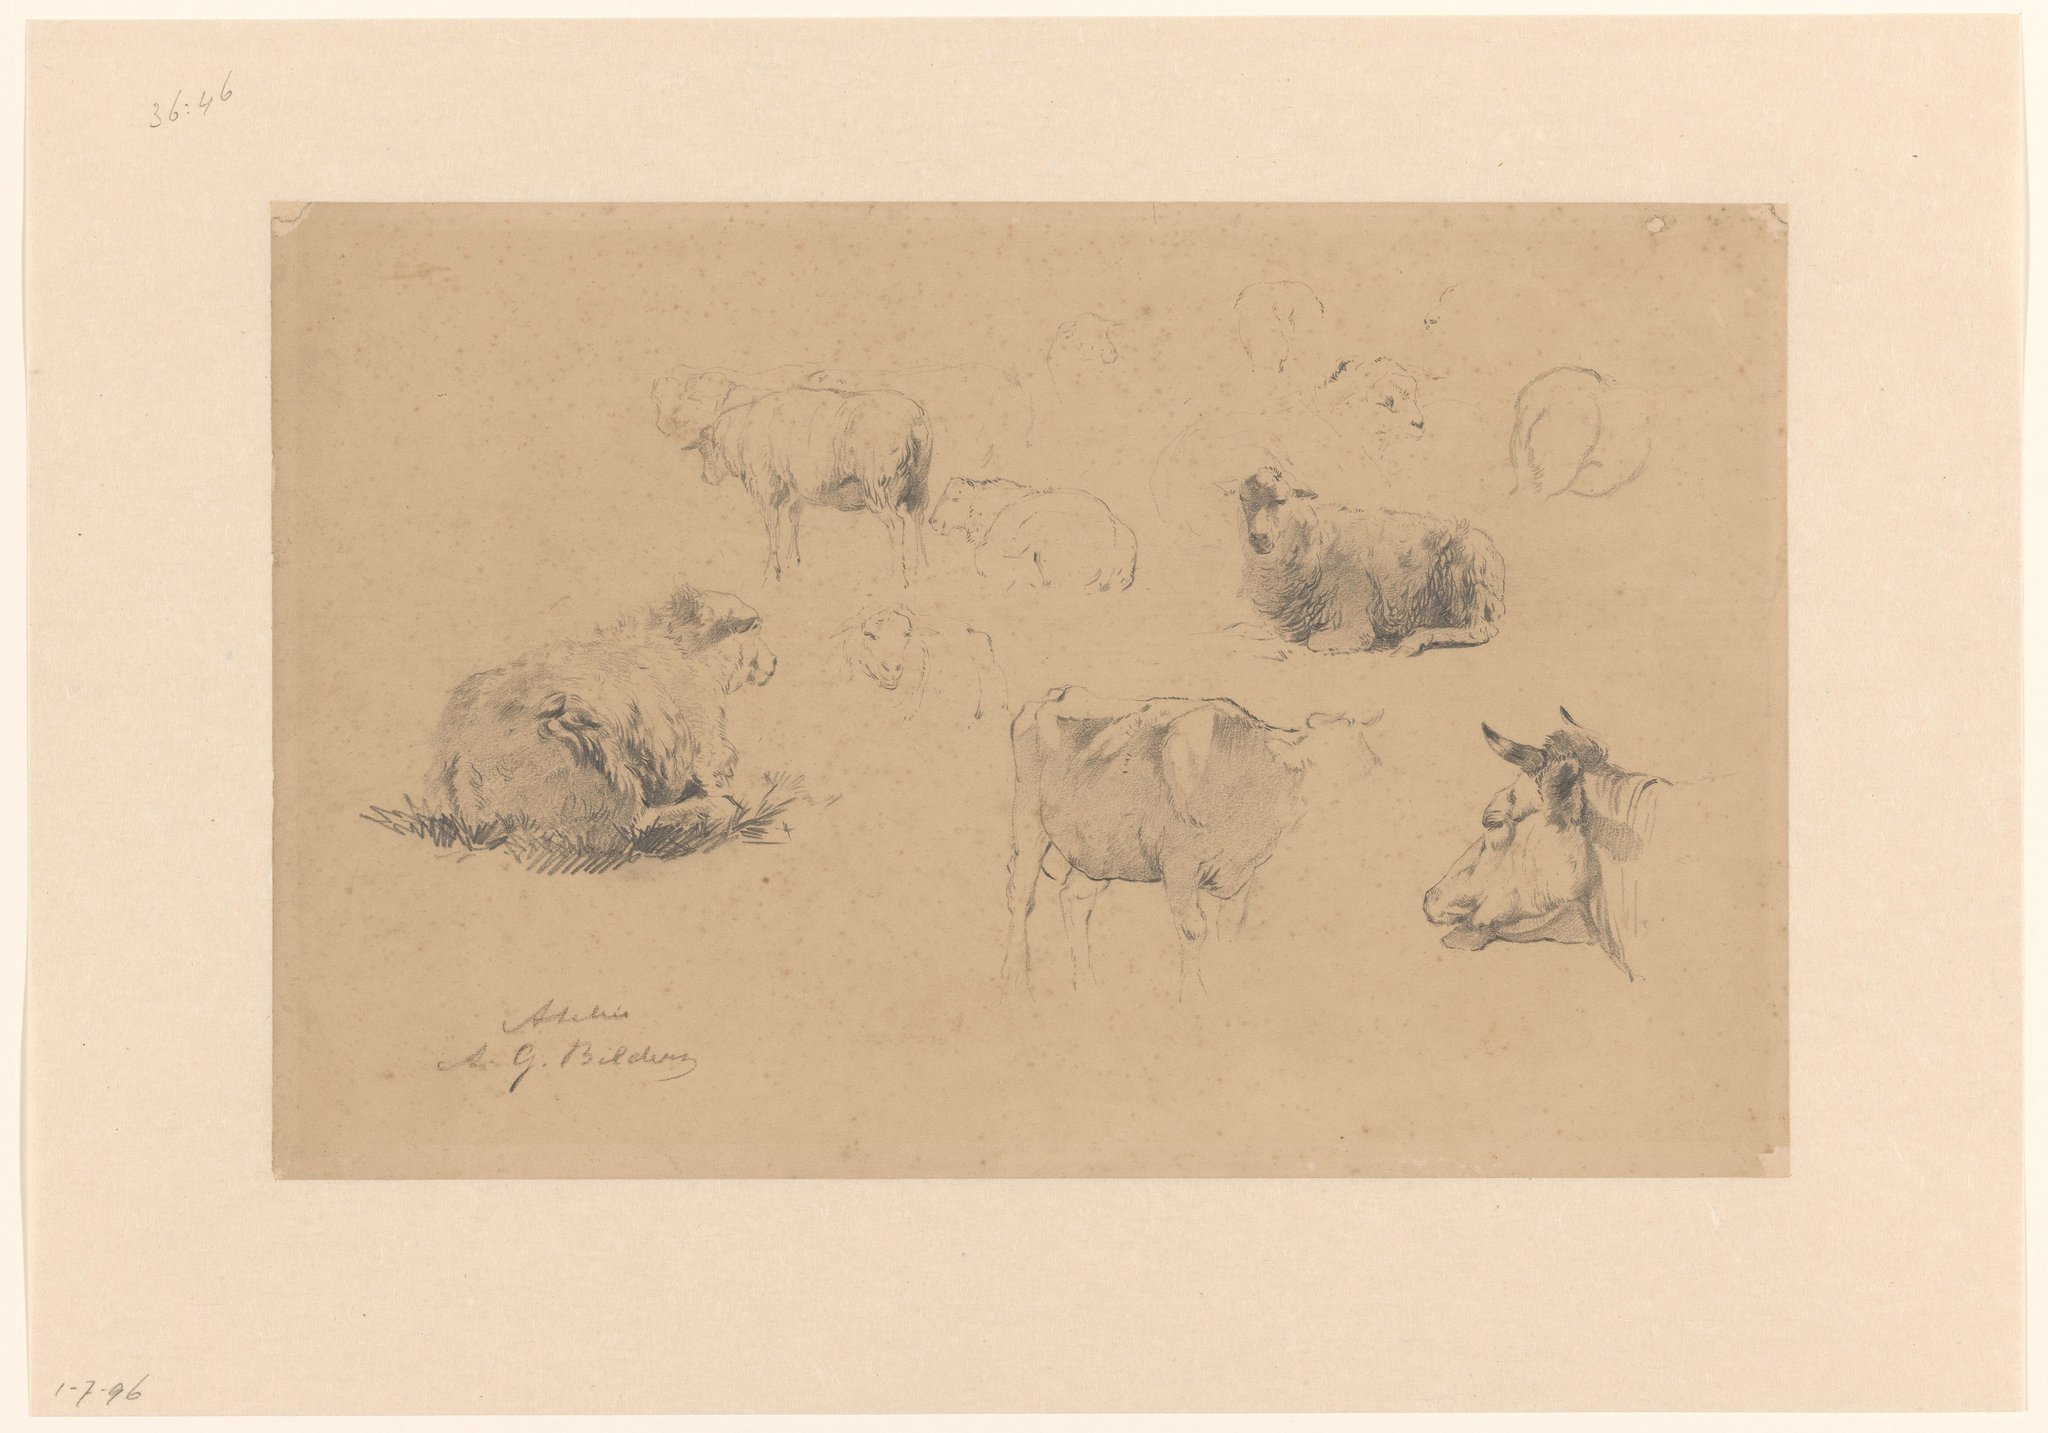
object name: drawing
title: Schetsblad met studies van schapen en koeien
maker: gerard bilders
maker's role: draughtsman, print maker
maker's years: 1838-1865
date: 1848-1865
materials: chalk, paper, pencil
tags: cow, sheep